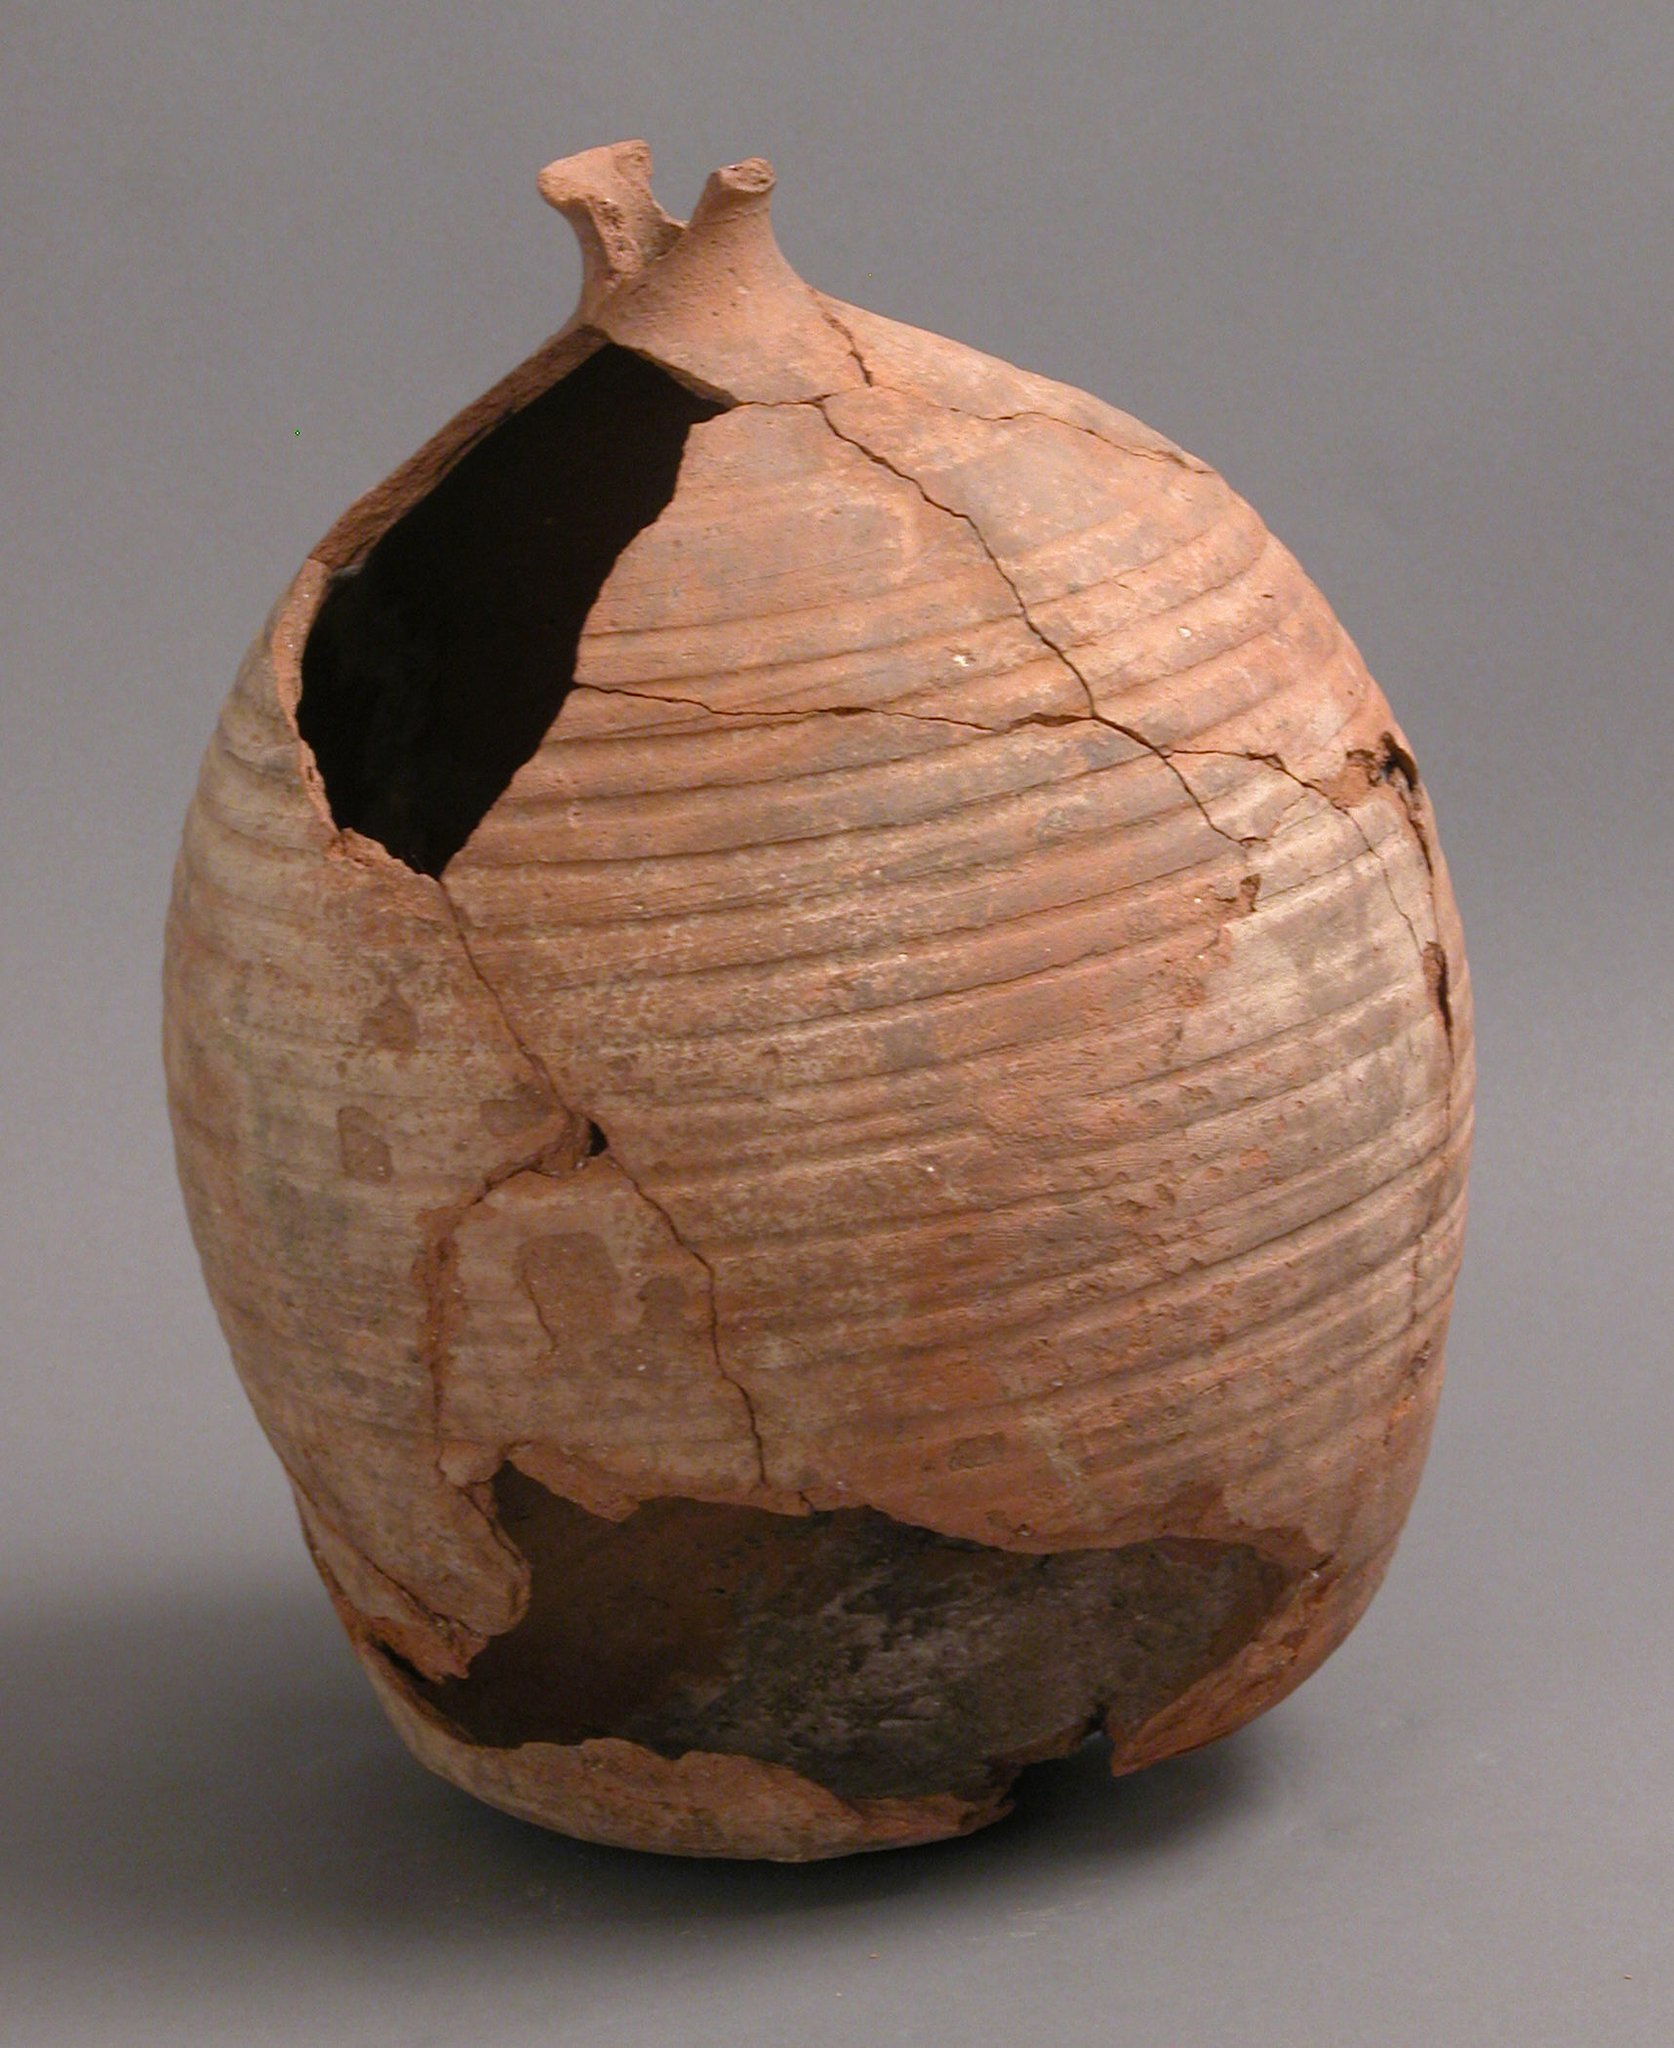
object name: jar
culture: coptic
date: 301-700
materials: earthenware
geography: egypt